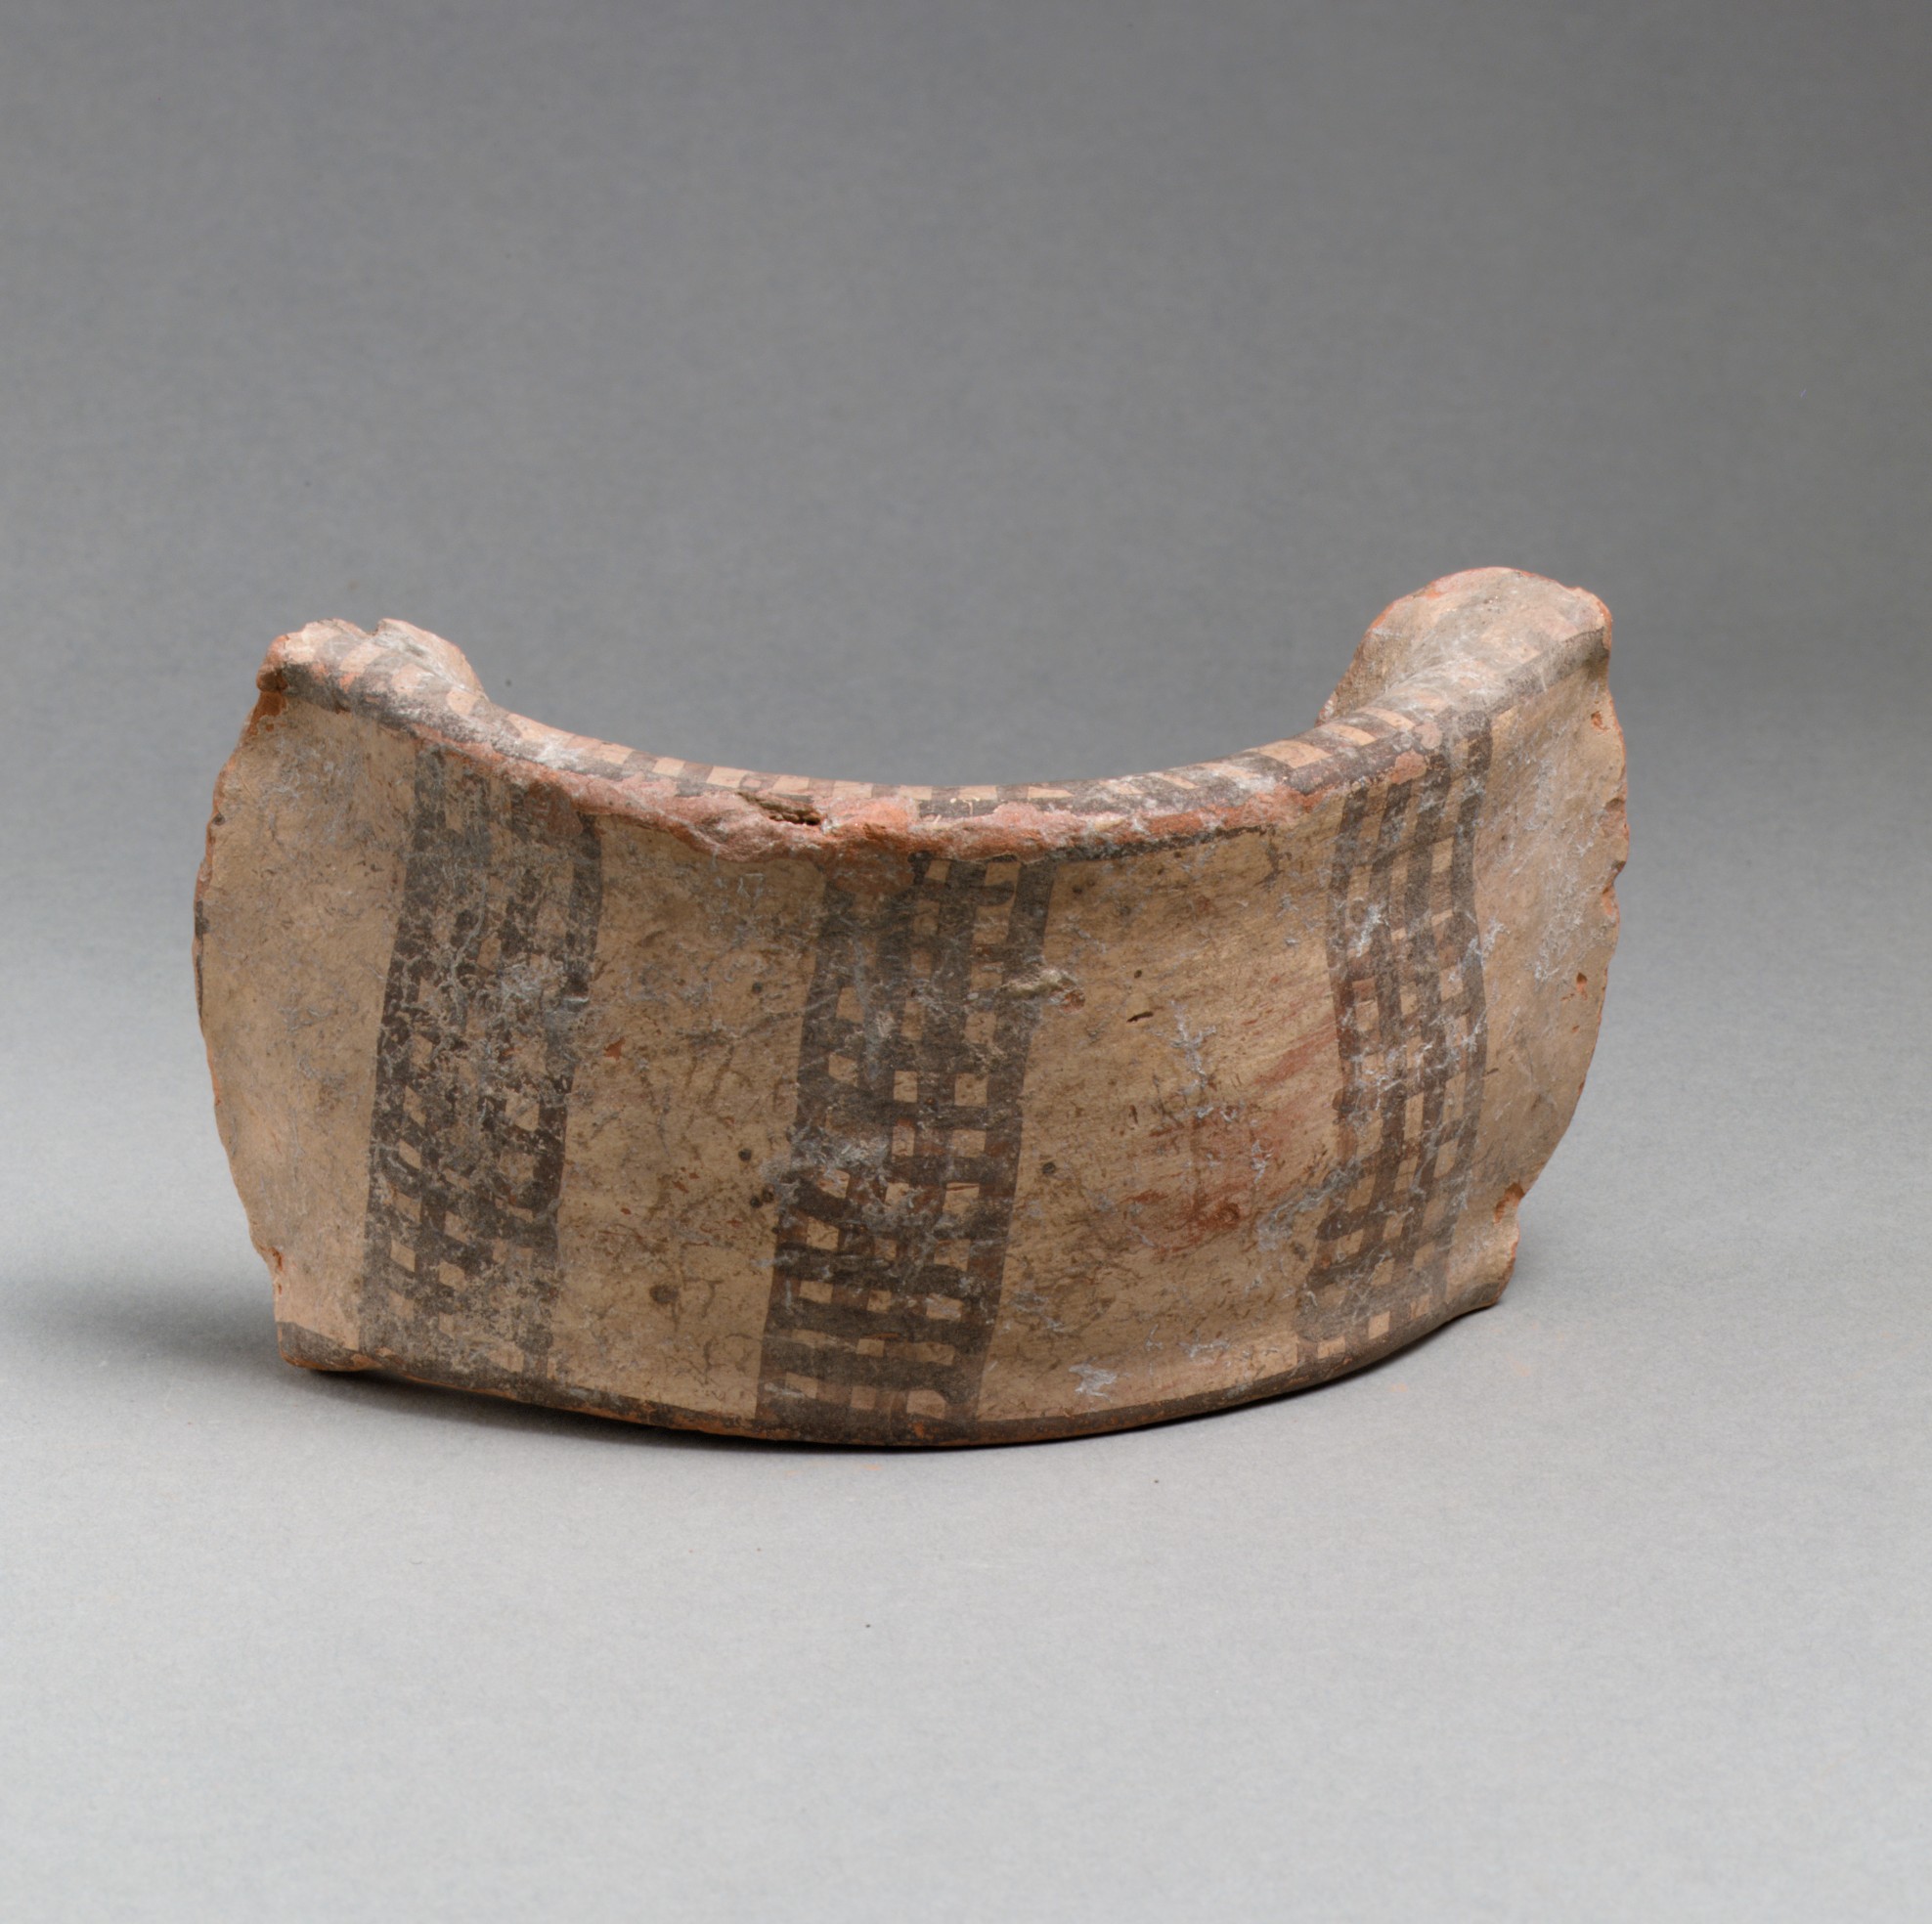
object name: vase fragment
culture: greek or lydian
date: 700-650 BCE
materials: terracotta